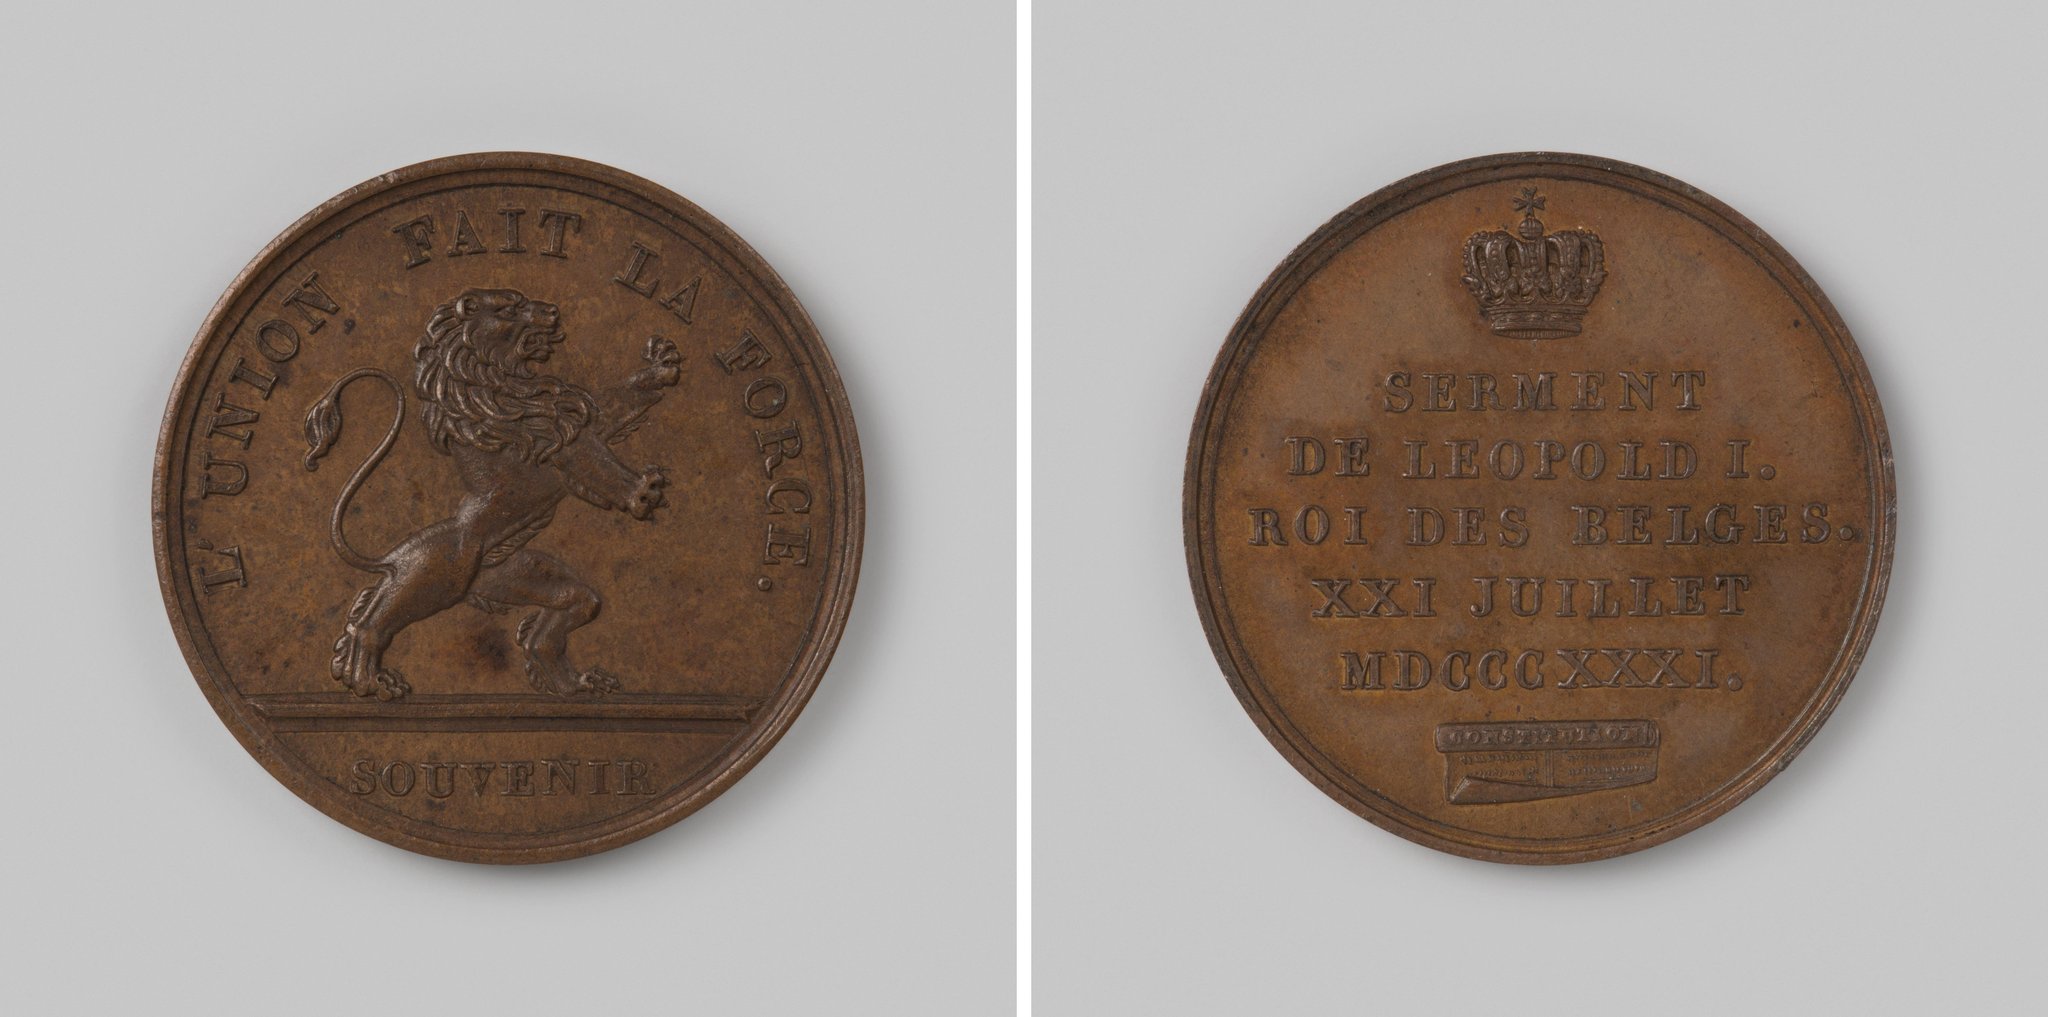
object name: strooipenning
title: Eed van Leopold van Saksen-Coburg op de constitutie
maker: joseph pierre braemt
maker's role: print maker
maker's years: 1796-1864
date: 1831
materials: bronze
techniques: striking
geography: brussels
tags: laeken, leopold i (koning der belgen), brussels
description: Bronzen penning. Voorzijde: staande leeuw binnen omschrift; afsnede: opschrift. Keerzijde: opschrift tussenkroon en half afgewikklede rol papier met opschrift